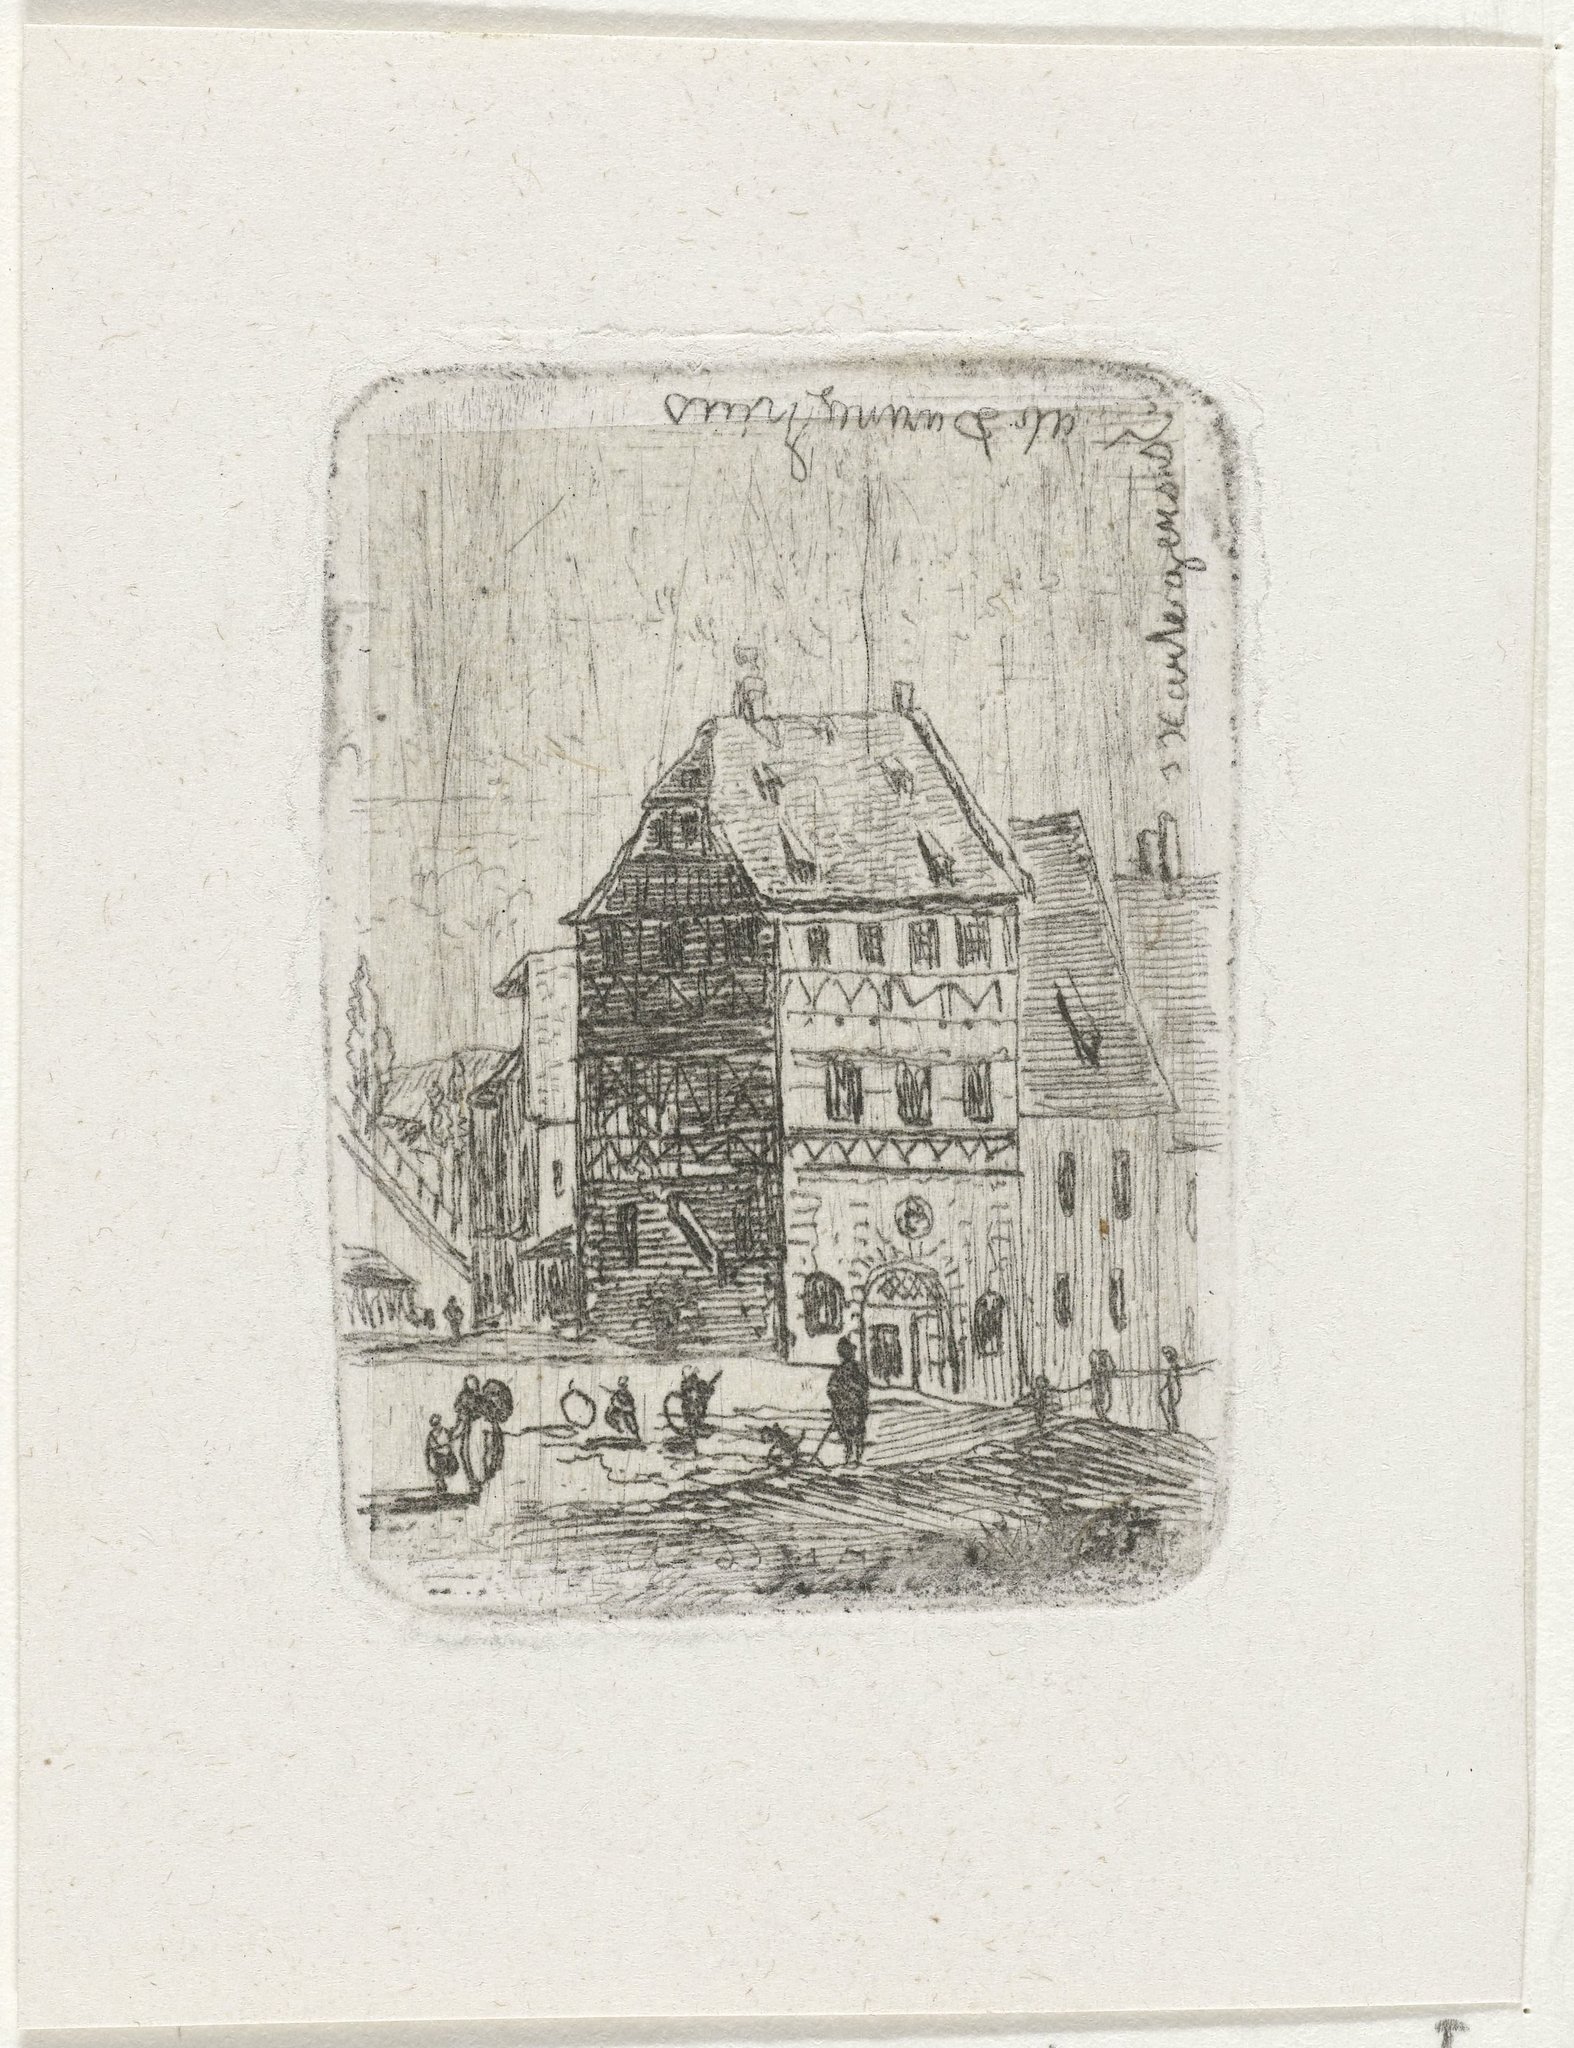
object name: print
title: Dürers huis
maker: joseph hartogensis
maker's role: painter, print maker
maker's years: 1822-1865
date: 1837-1865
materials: paper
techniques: etching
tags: urban housing, city-view in general; 'veduta' (+ city(-scape) with figures, staffage)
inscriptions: collector's mark: Lugt 2228